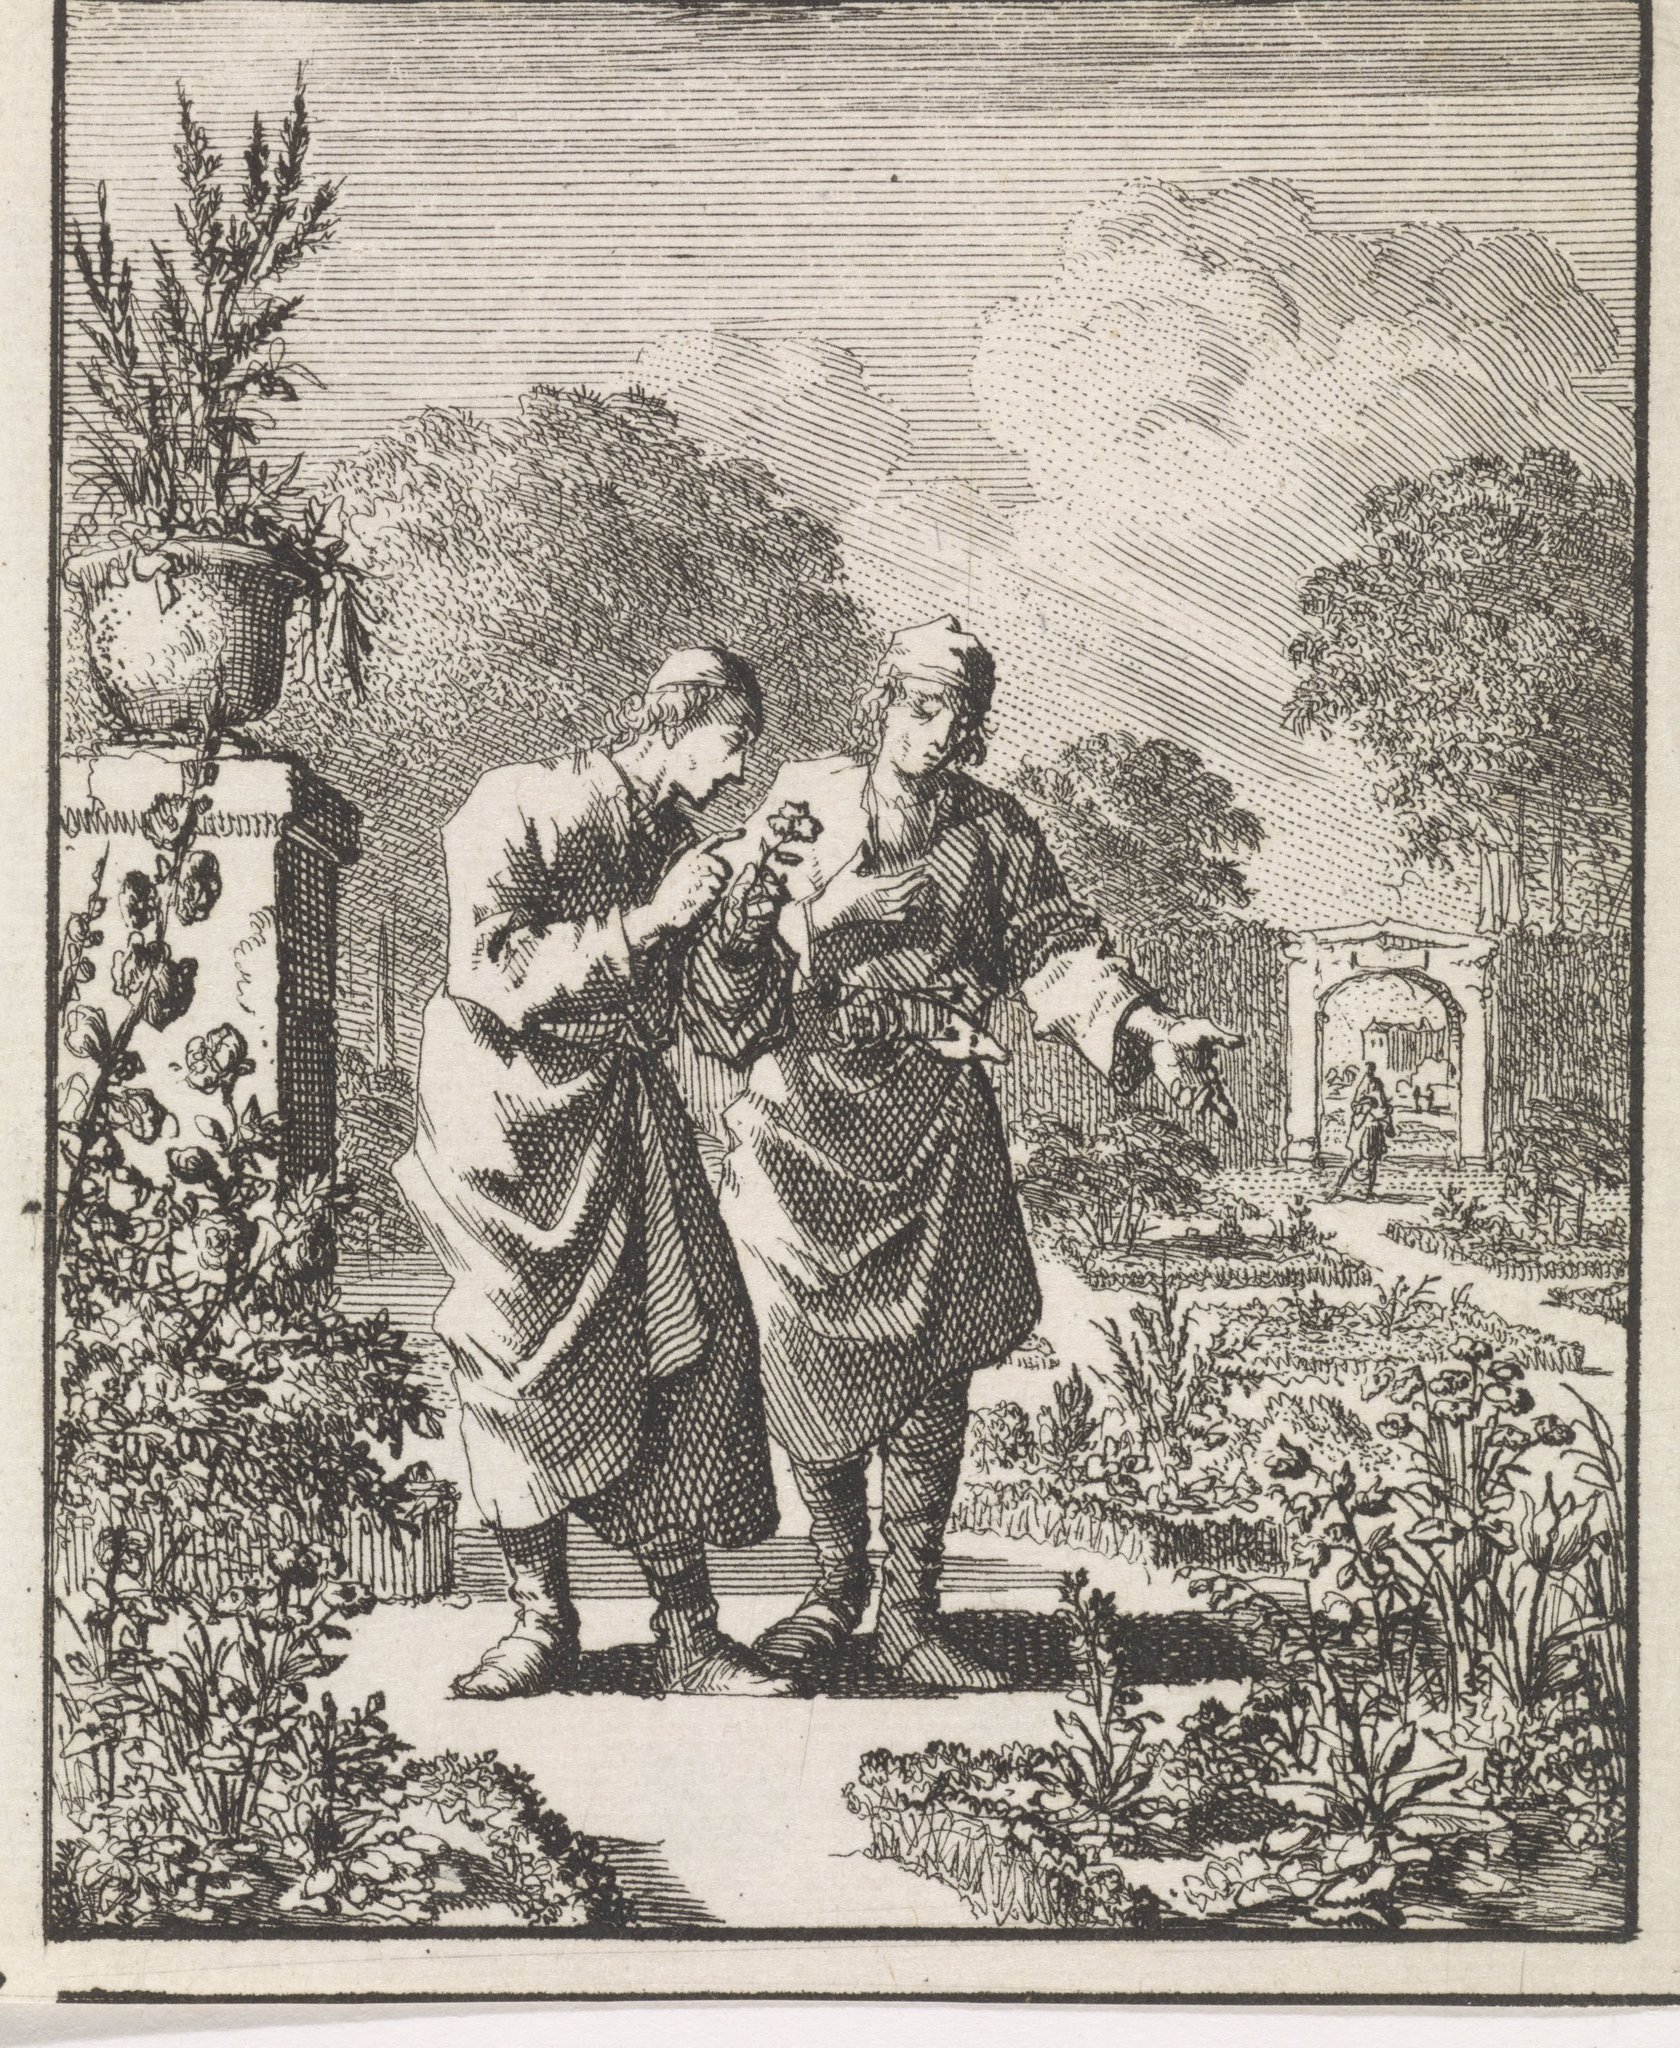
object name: book illustration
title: Twee mannen in een tuin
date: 1700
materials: paper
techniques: etching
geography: amsterdam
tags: enjoying nature ~ plants, herbs and flowers, flowers, garden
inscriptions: collector's mark: Lugt 2228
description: Boekillustratie voor Jan Huygen. Stichtelyke rymen op verscheiden stoffen. Amsterdam: Gedrukt door Jacobus van Herdenberg voor Jan Huygen, 1700, p. 132.